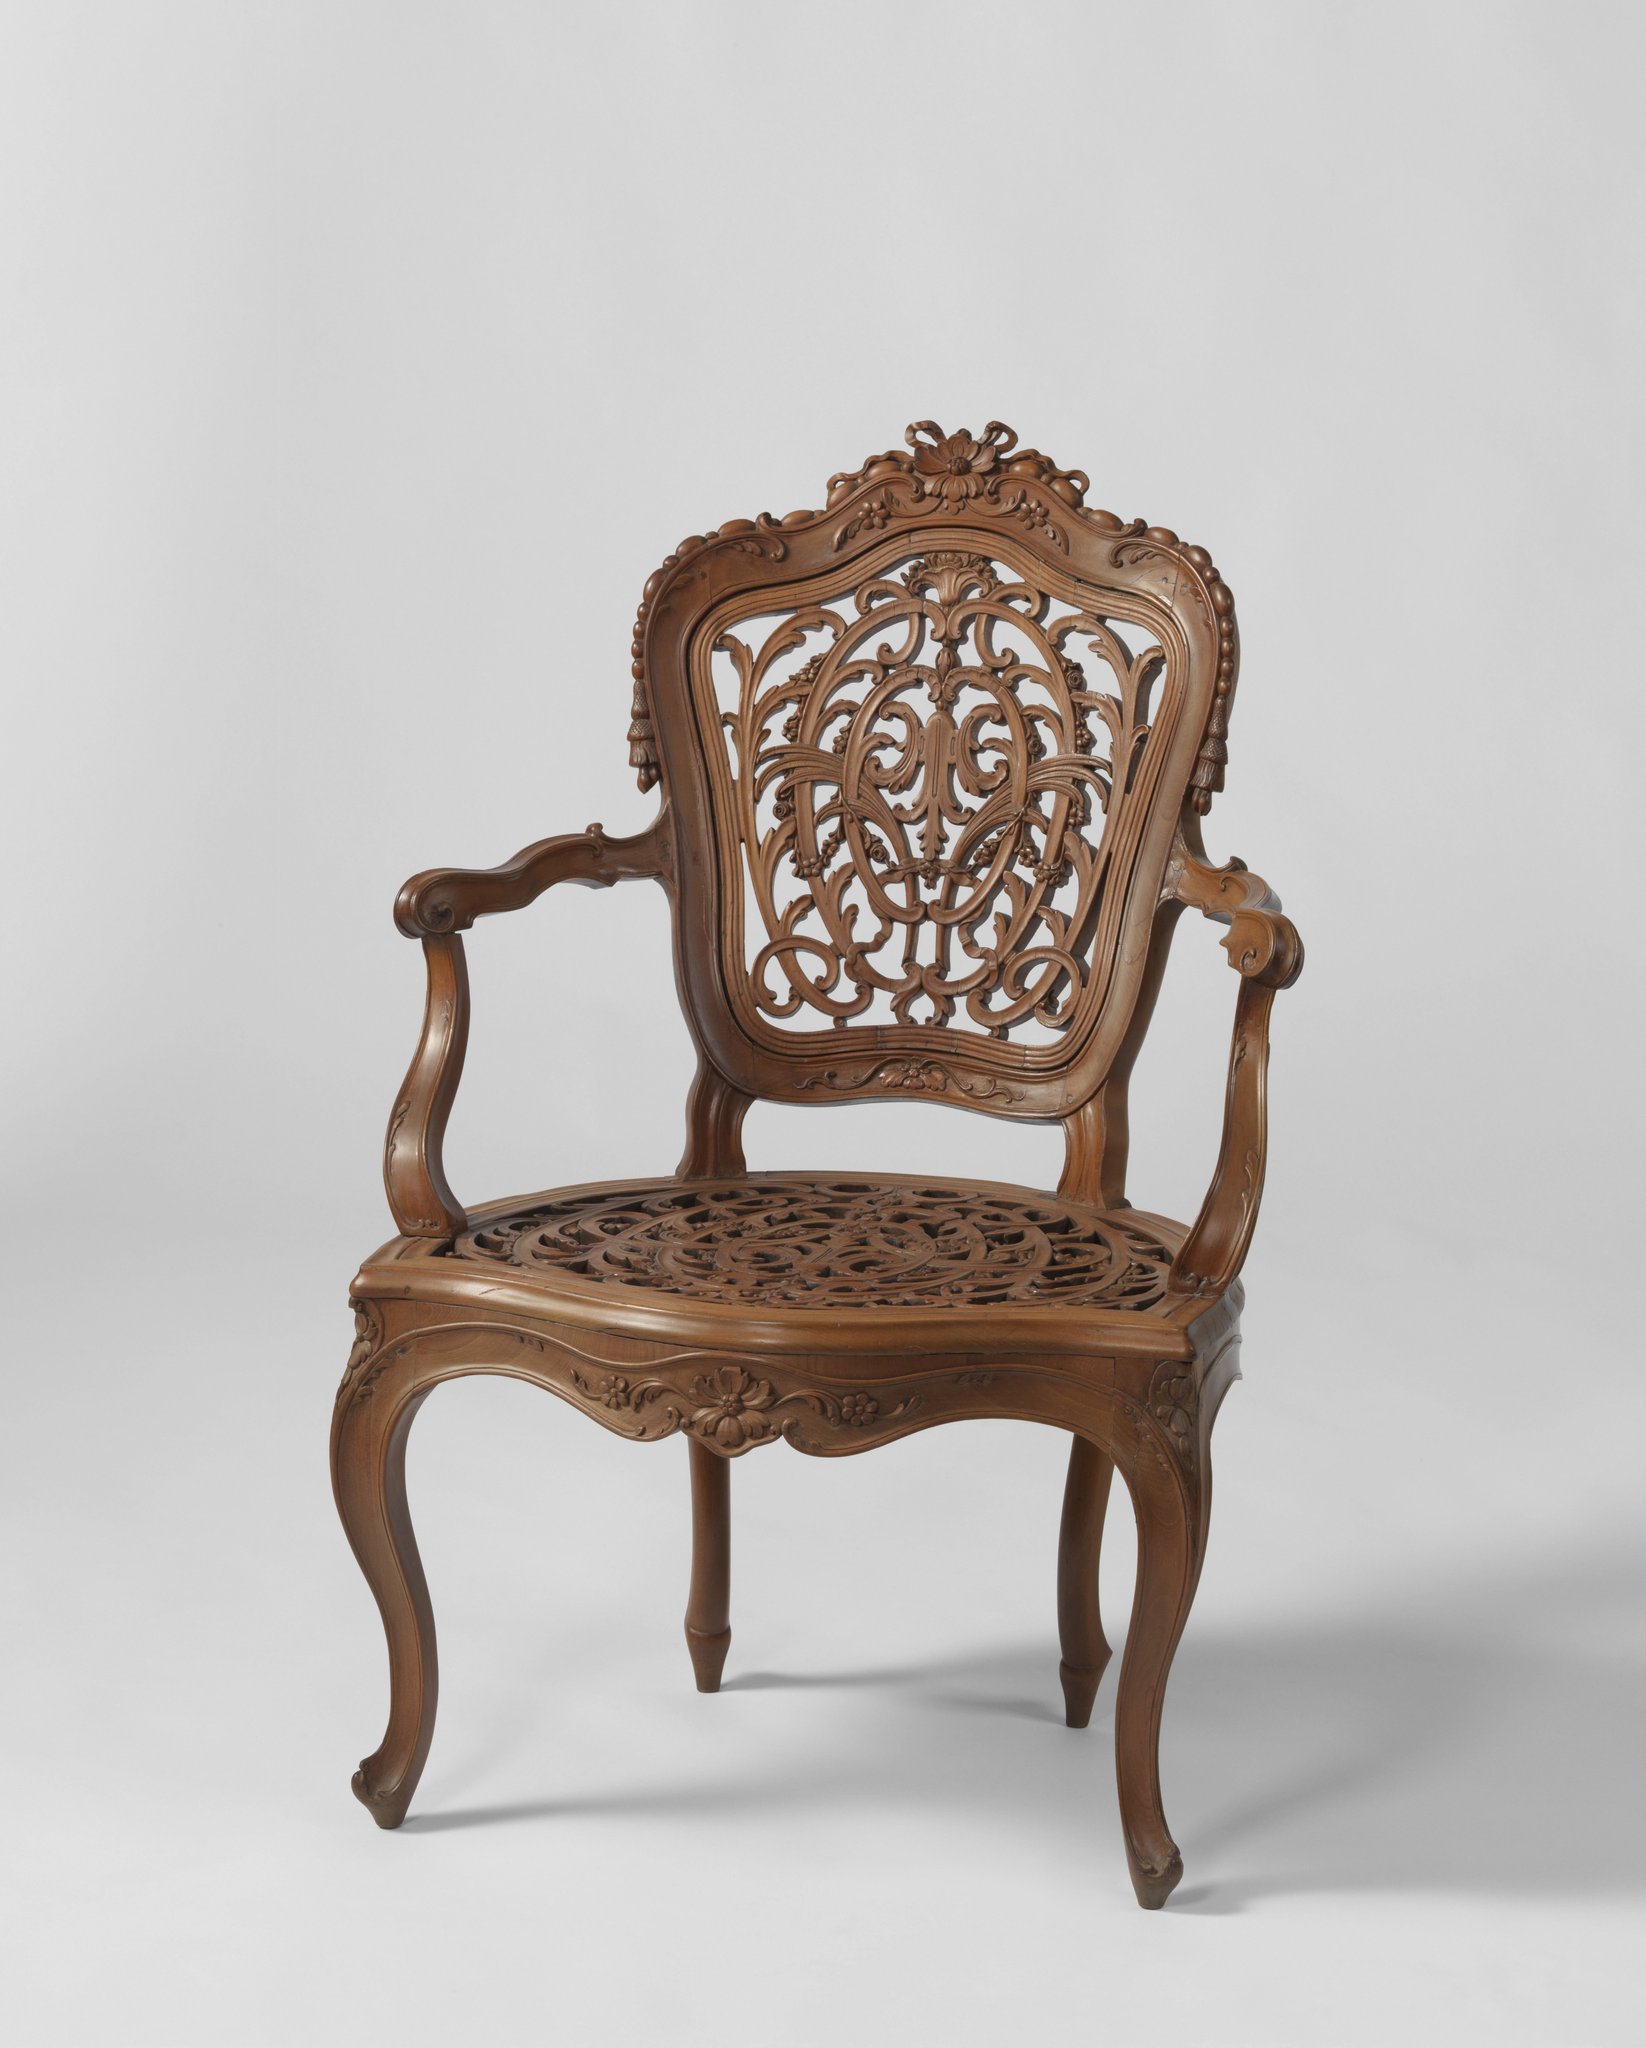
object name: armchair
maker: Anonymous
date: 1765-1775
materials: wood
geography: northern italy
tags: flowers ~ ornament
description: The back and seat of this armchair consist of open-work in a richly carved pattern. The piece of furniture is a virtuoso masterpiece, a splendid demonstration of its maker’s abilities. The chair’s utilitarian function is secondary to the elaborate execution; comfort is not a priority here.